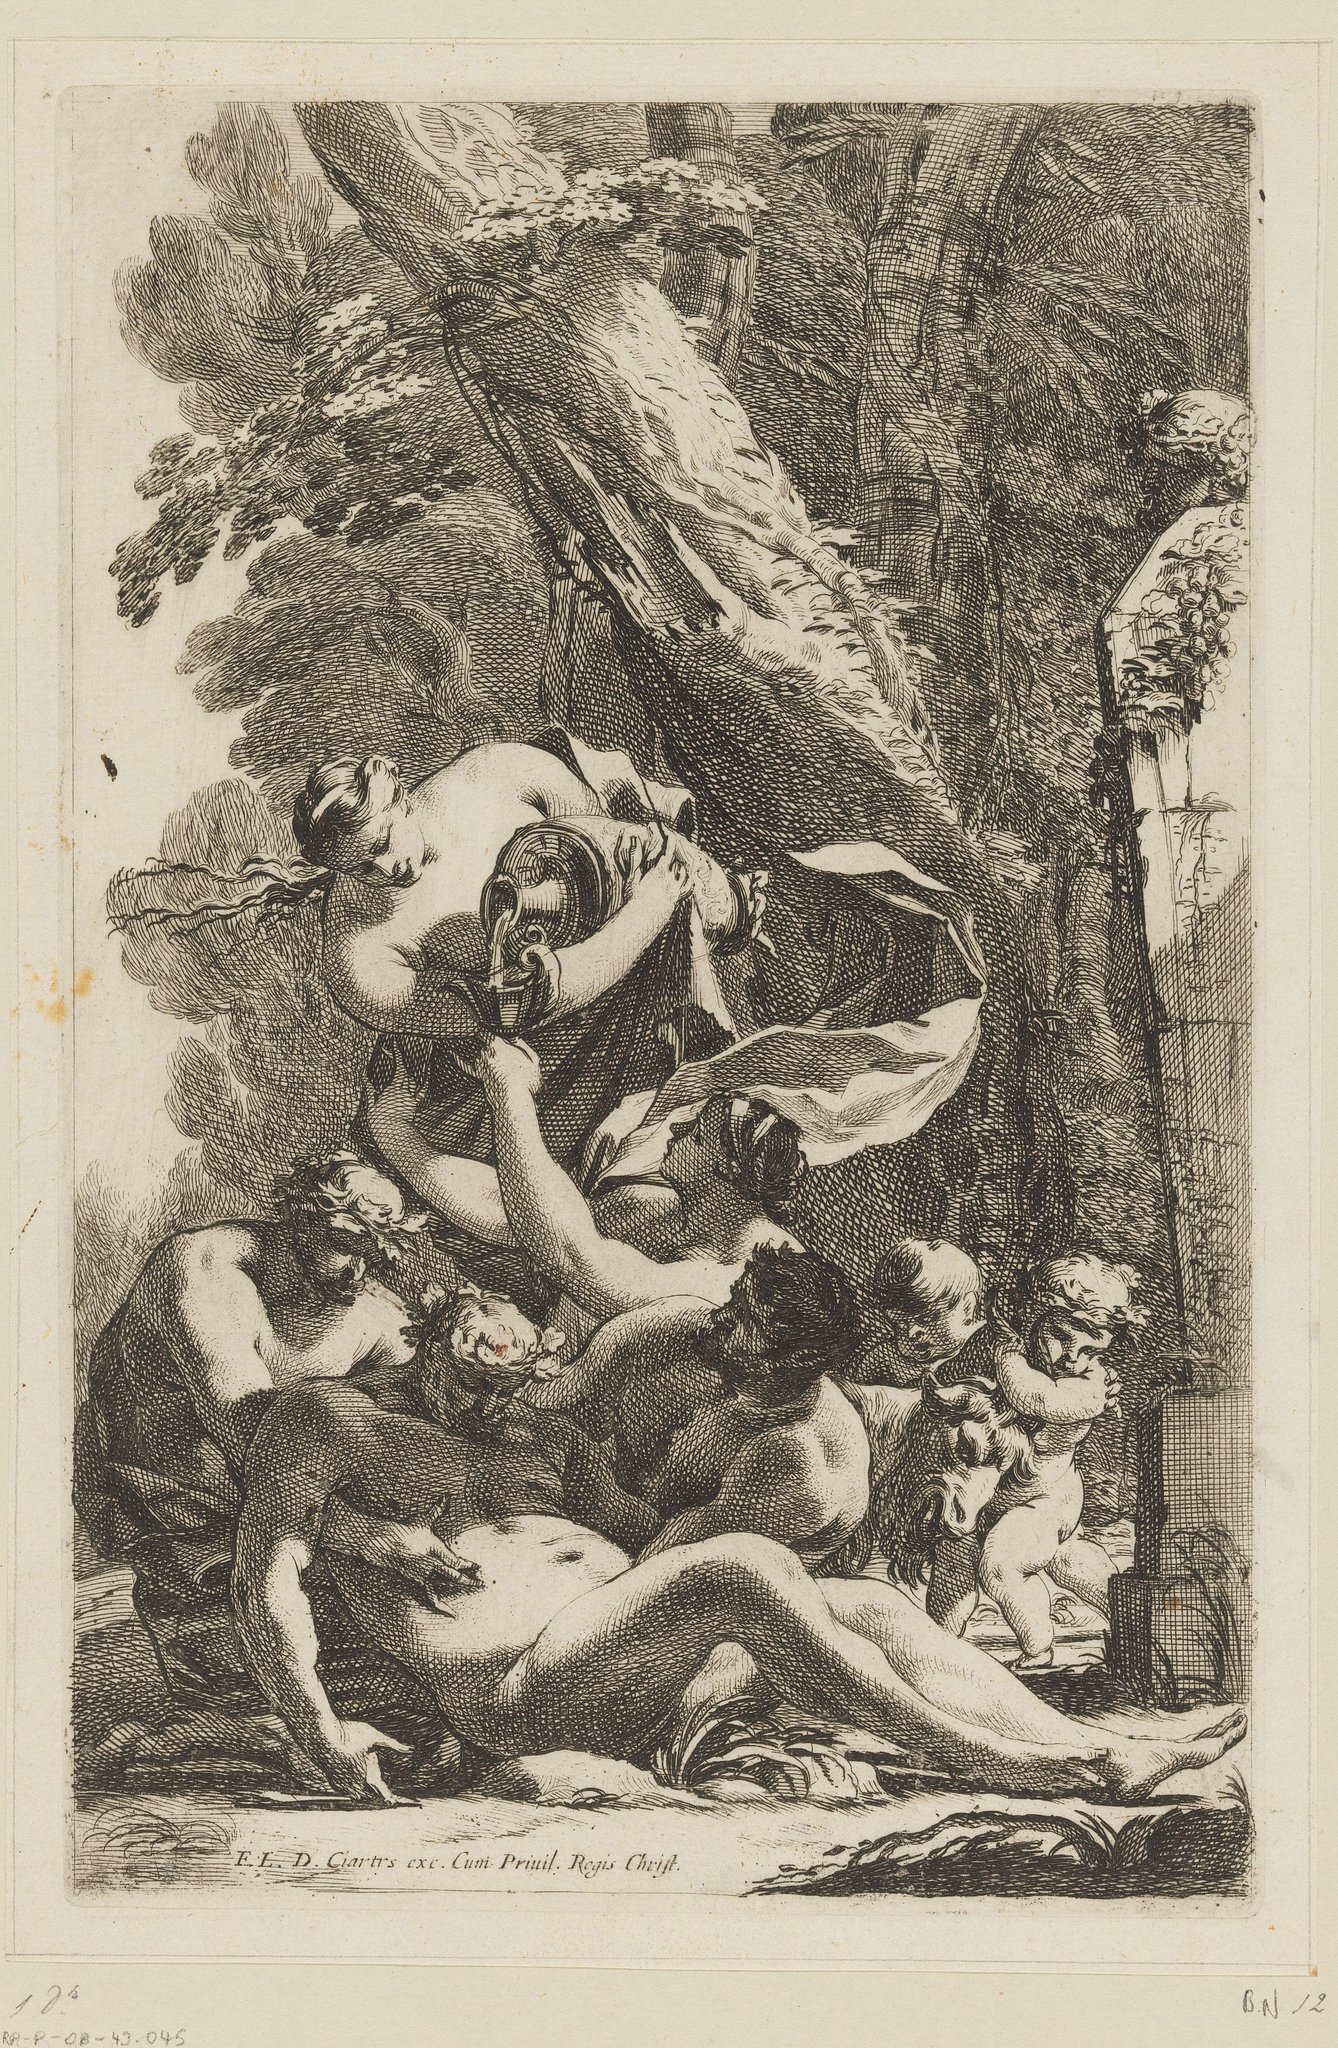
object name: print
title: Bacchanalen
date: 1626-1647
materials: paper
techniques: engraving, etching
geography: chartres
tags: (story of) silenus, drinking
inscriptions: collector's mark: Lugt 240